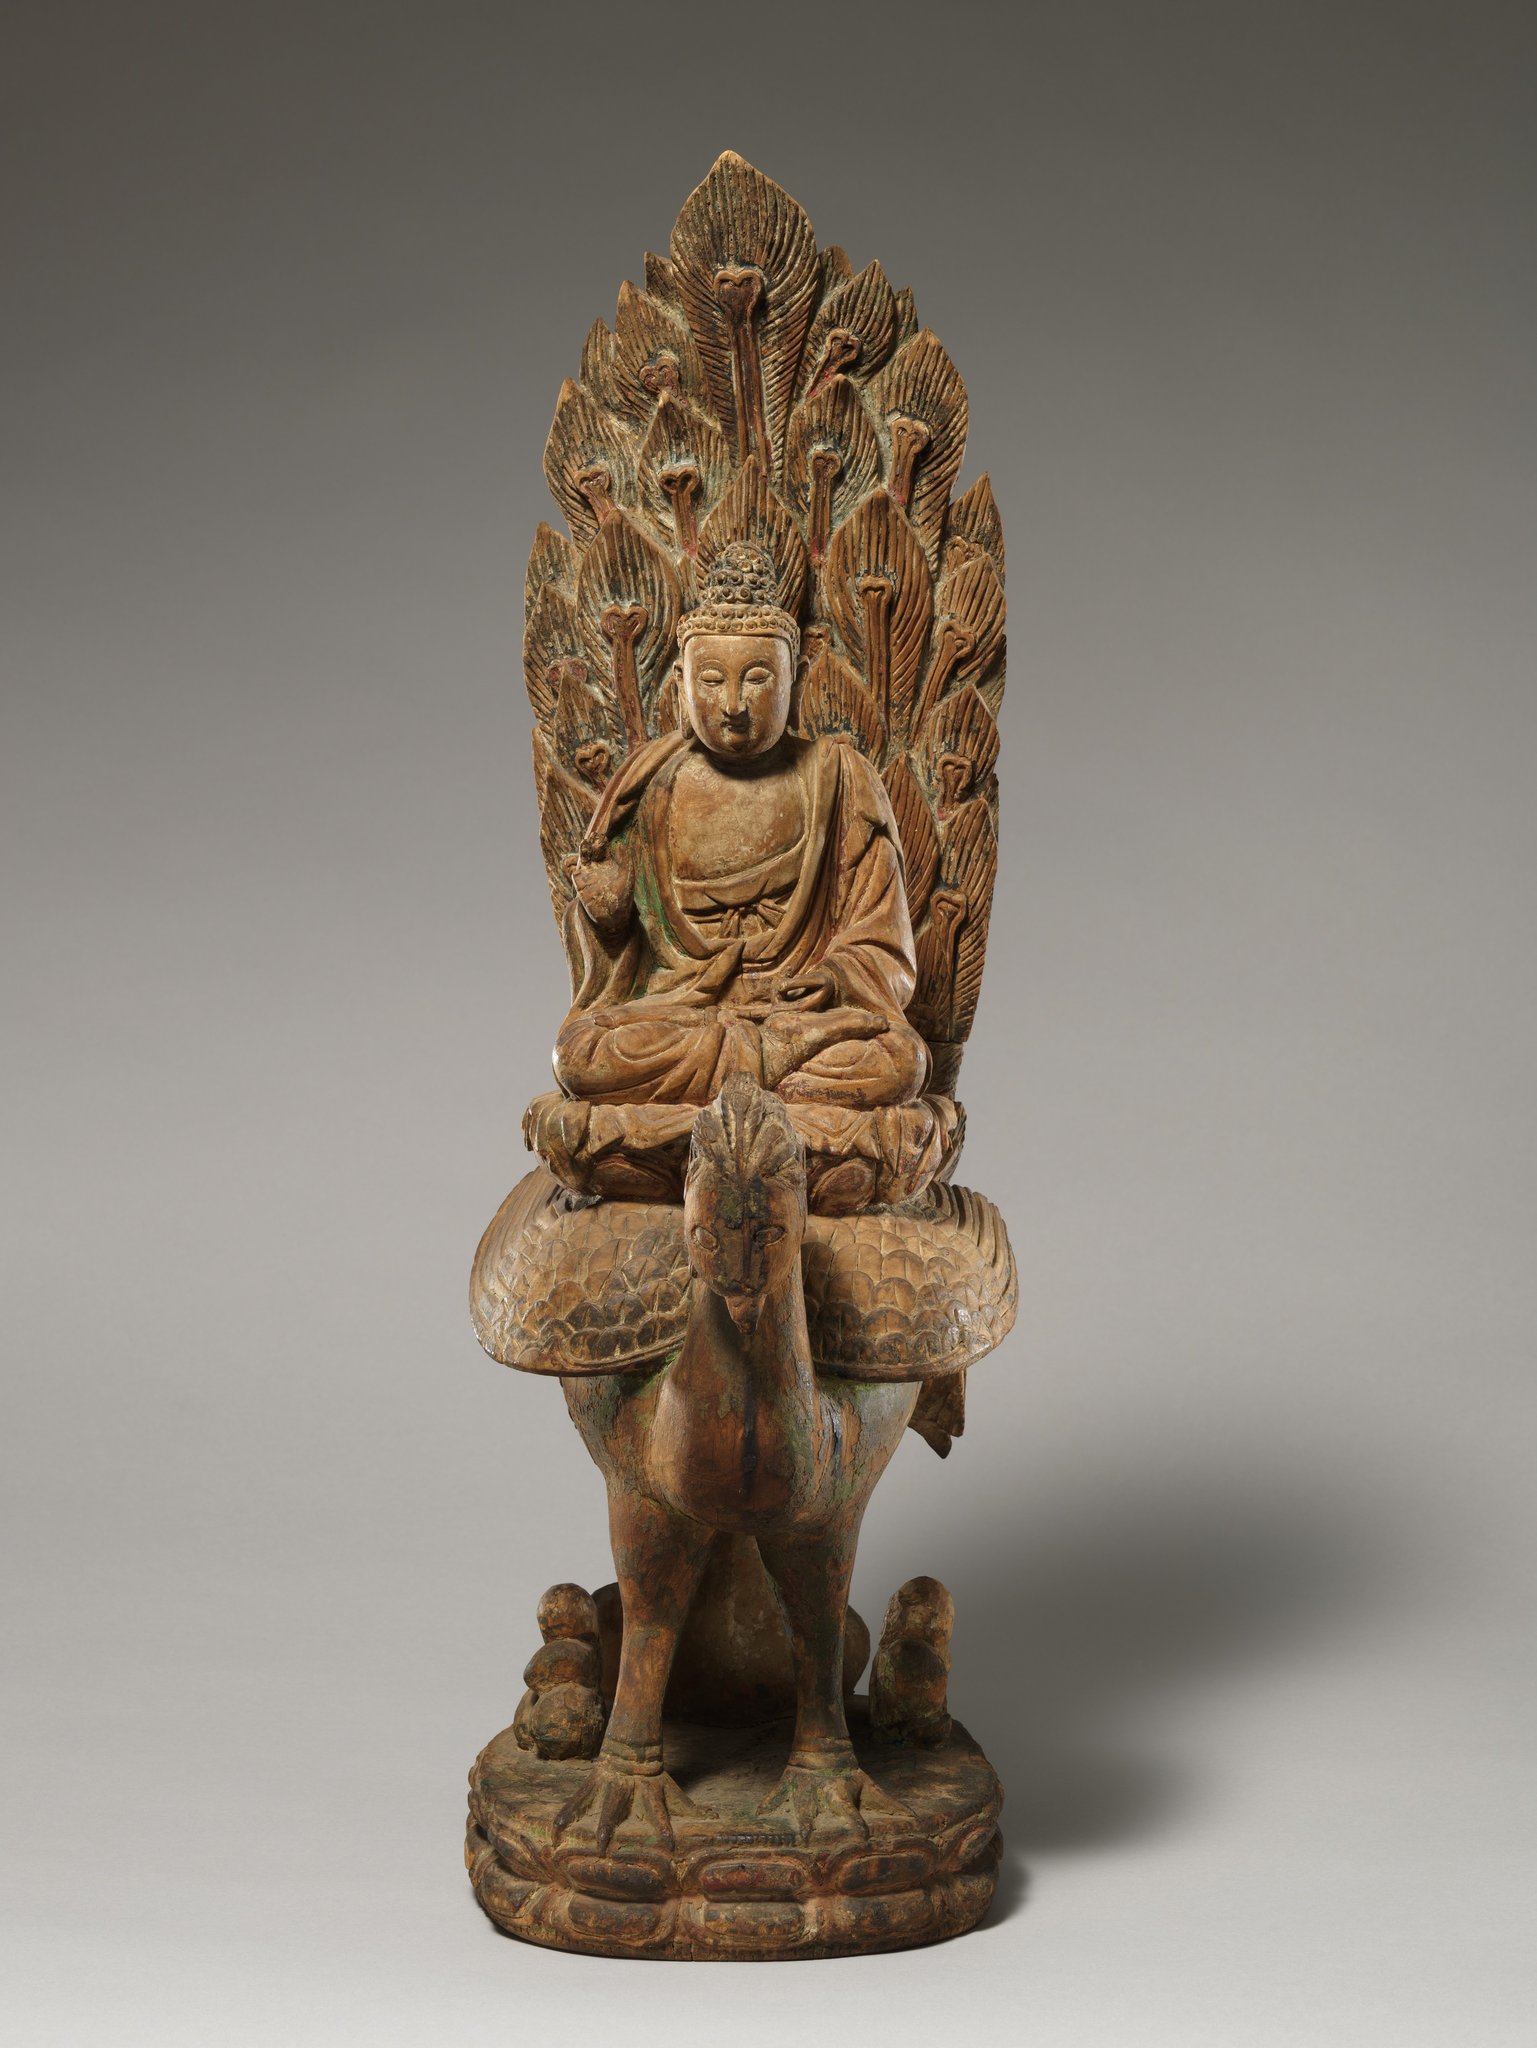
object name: figure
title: Buddha, possibly Amitabha, on a peacock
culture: chinese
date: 1401-1500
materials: wood, pigment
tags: peacocks,buddha